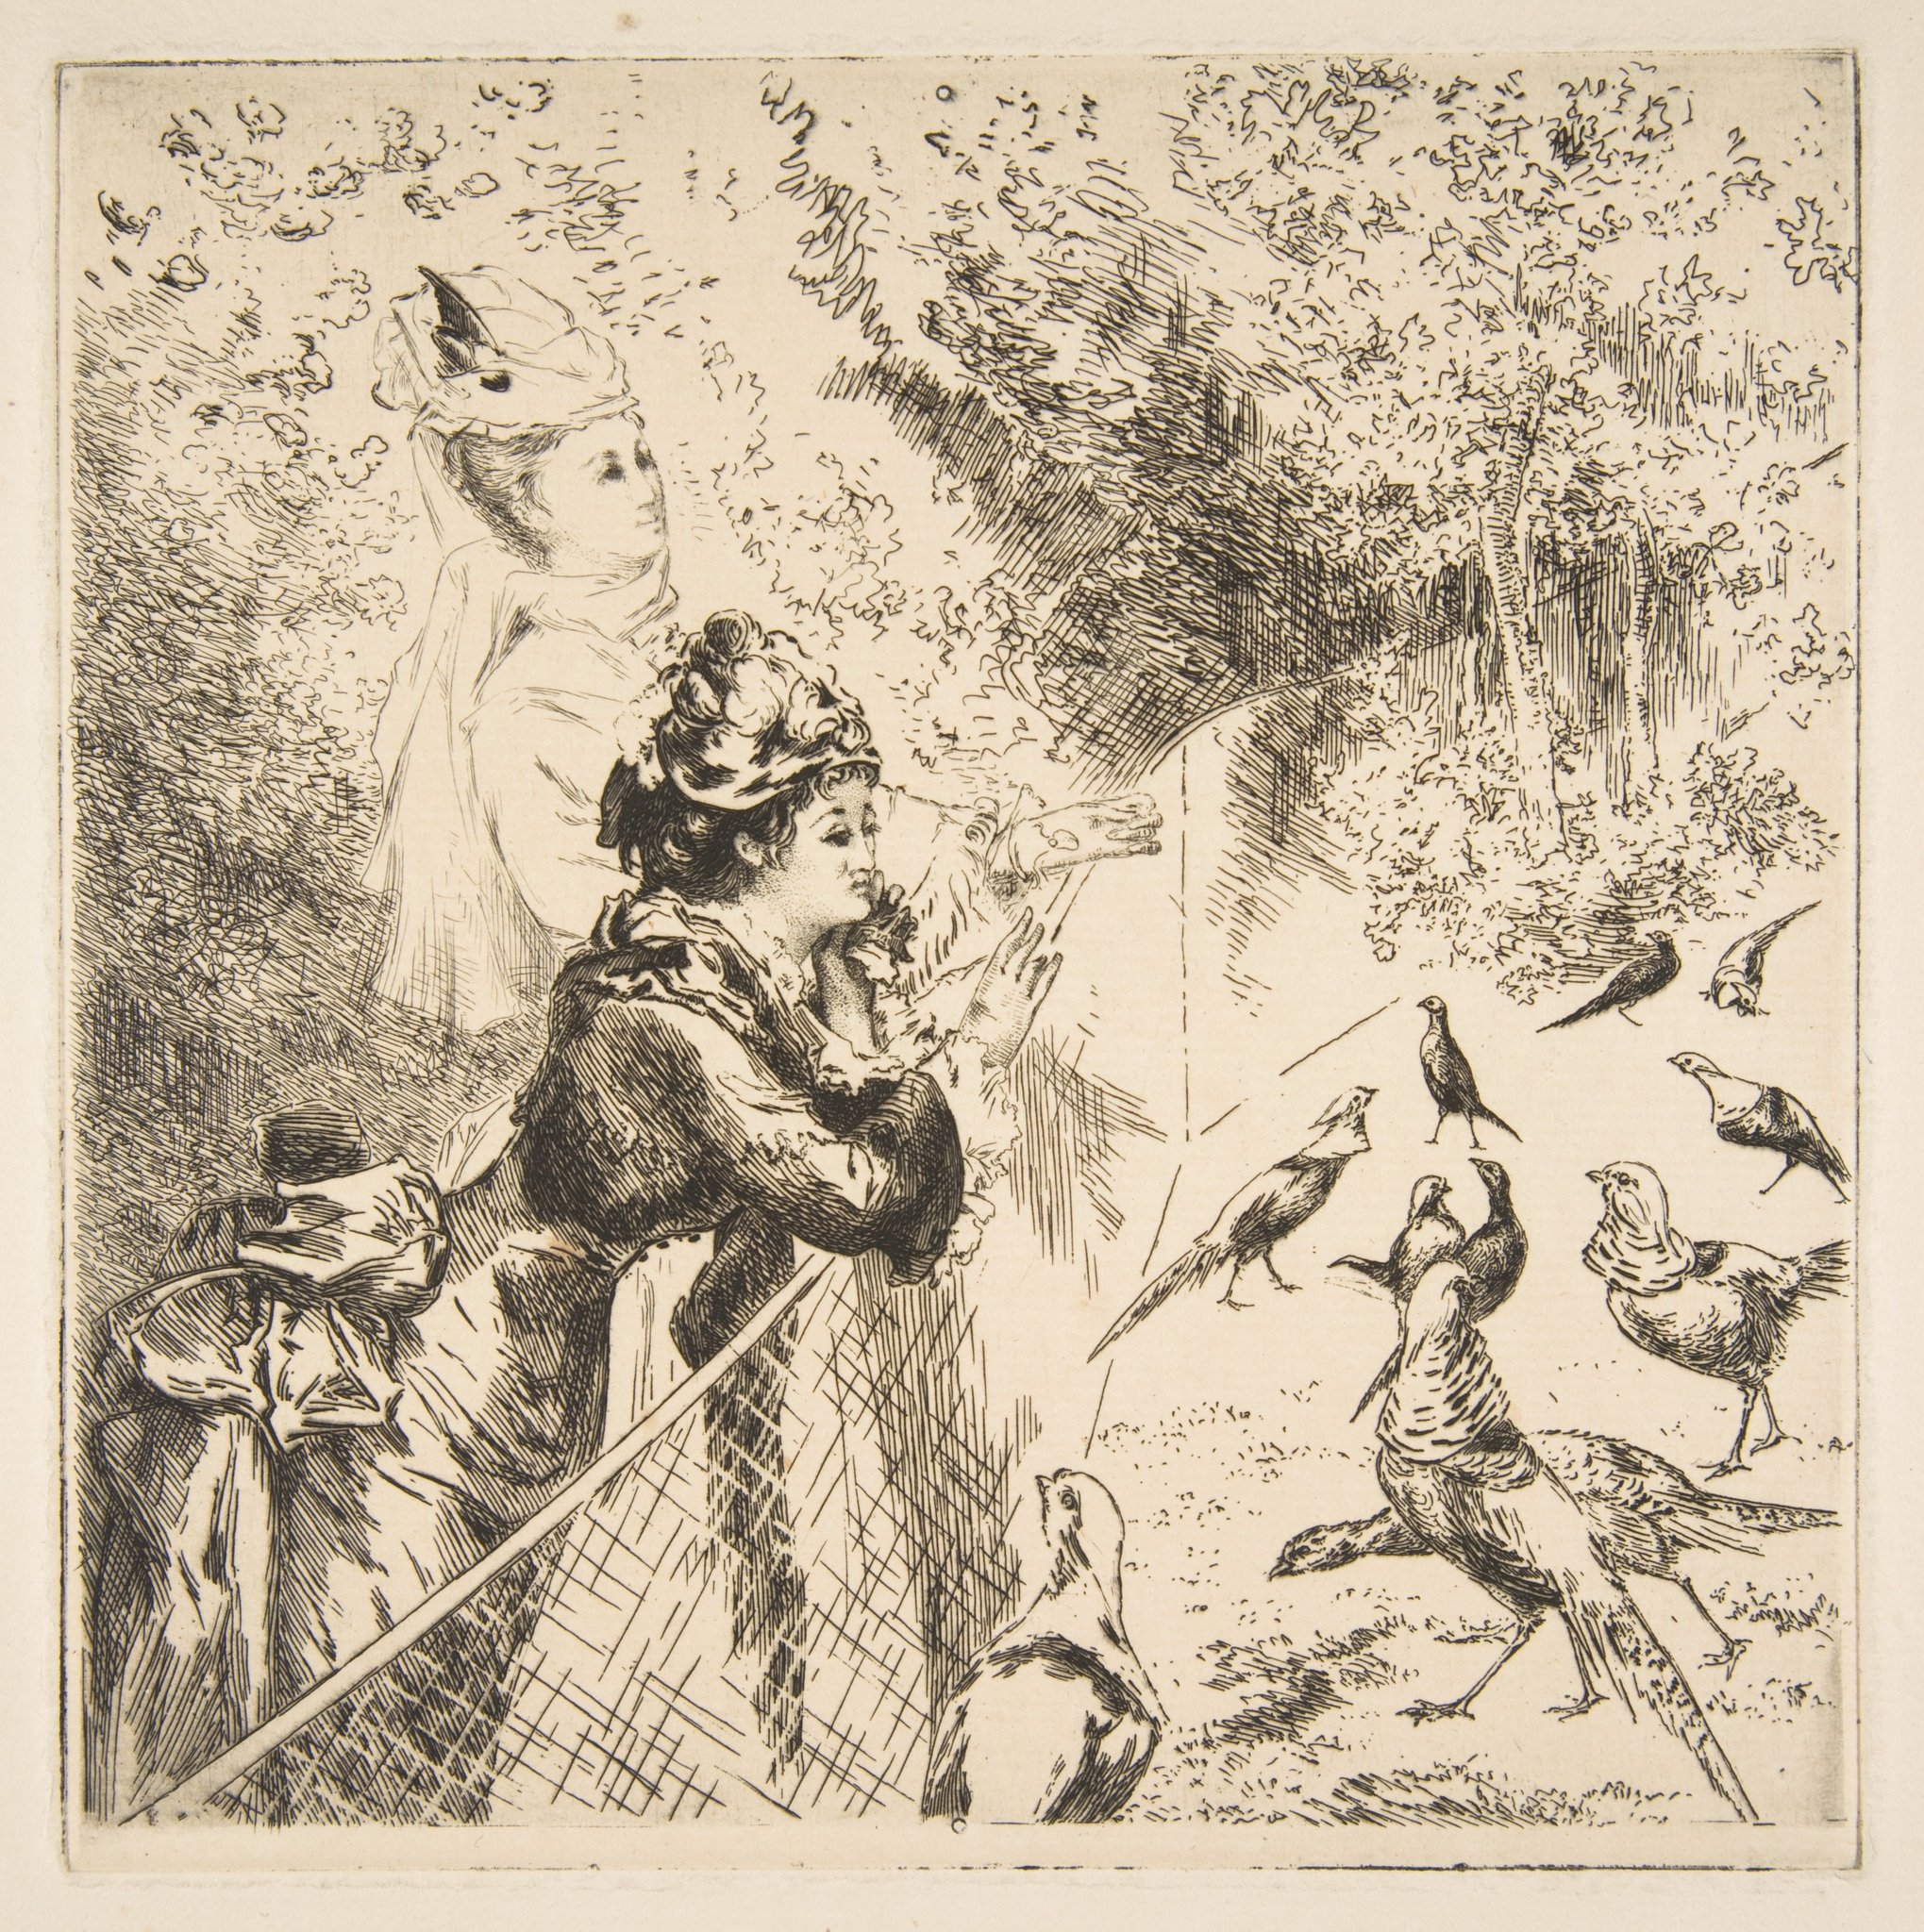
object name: print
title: In the Zoological Garden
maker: félix bracquemond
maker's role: artist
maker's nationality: french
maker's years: 1833-1914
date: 1873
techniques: etching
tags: birds,gardens,women